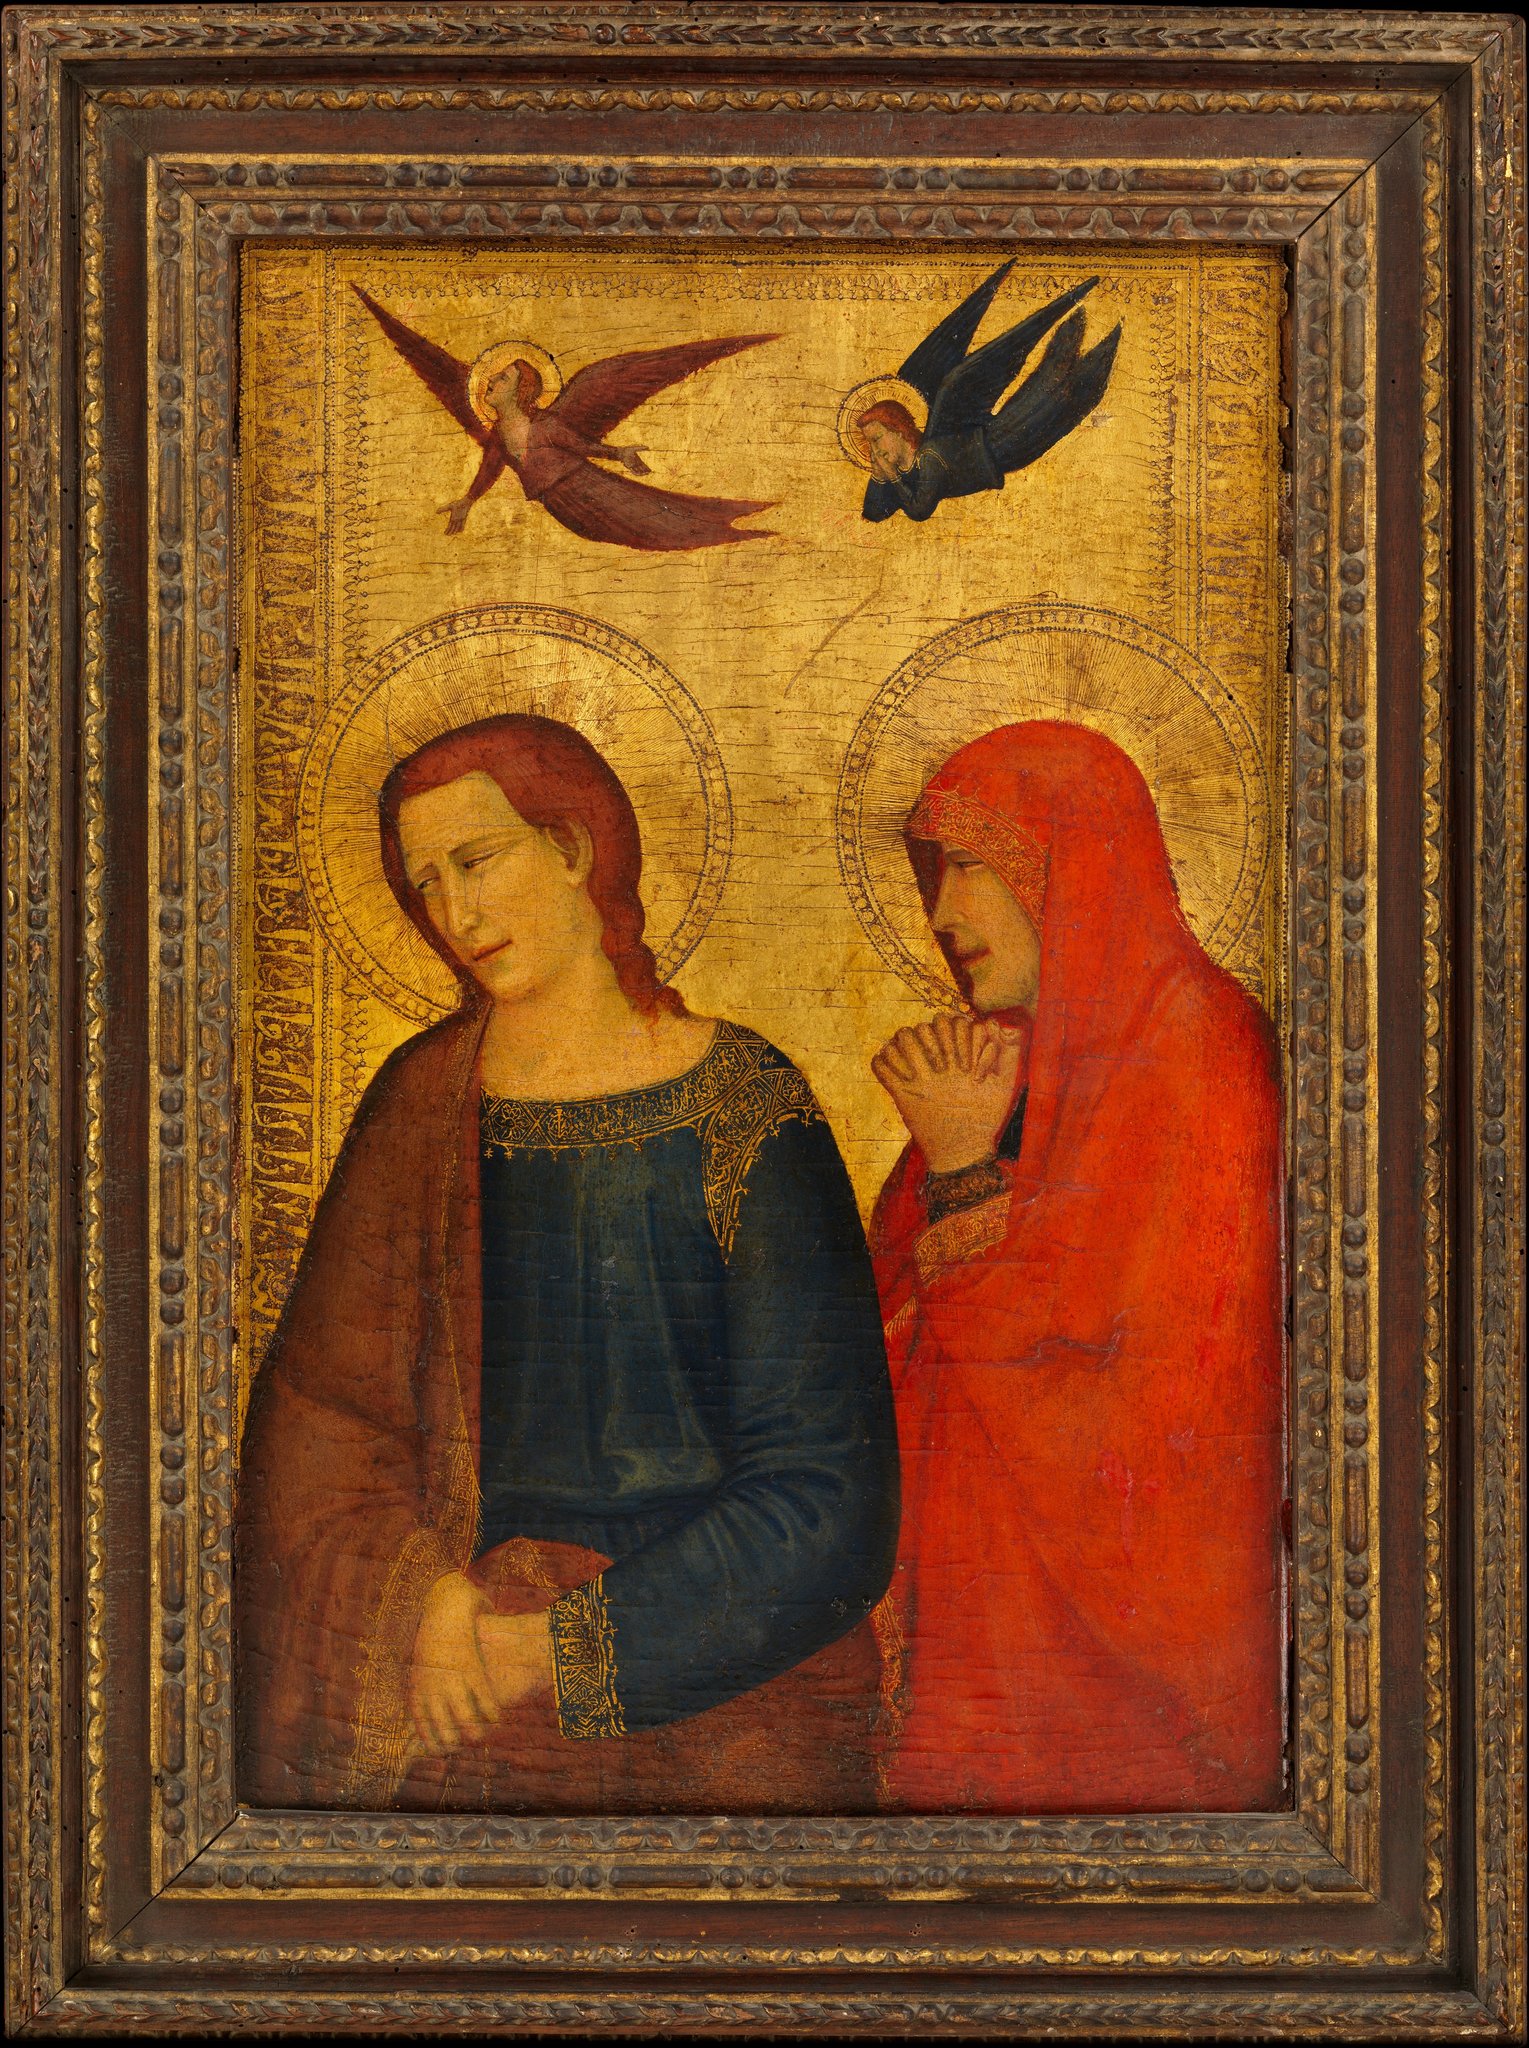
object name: frame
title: Cassetta frame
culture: italian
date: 1520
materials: wood